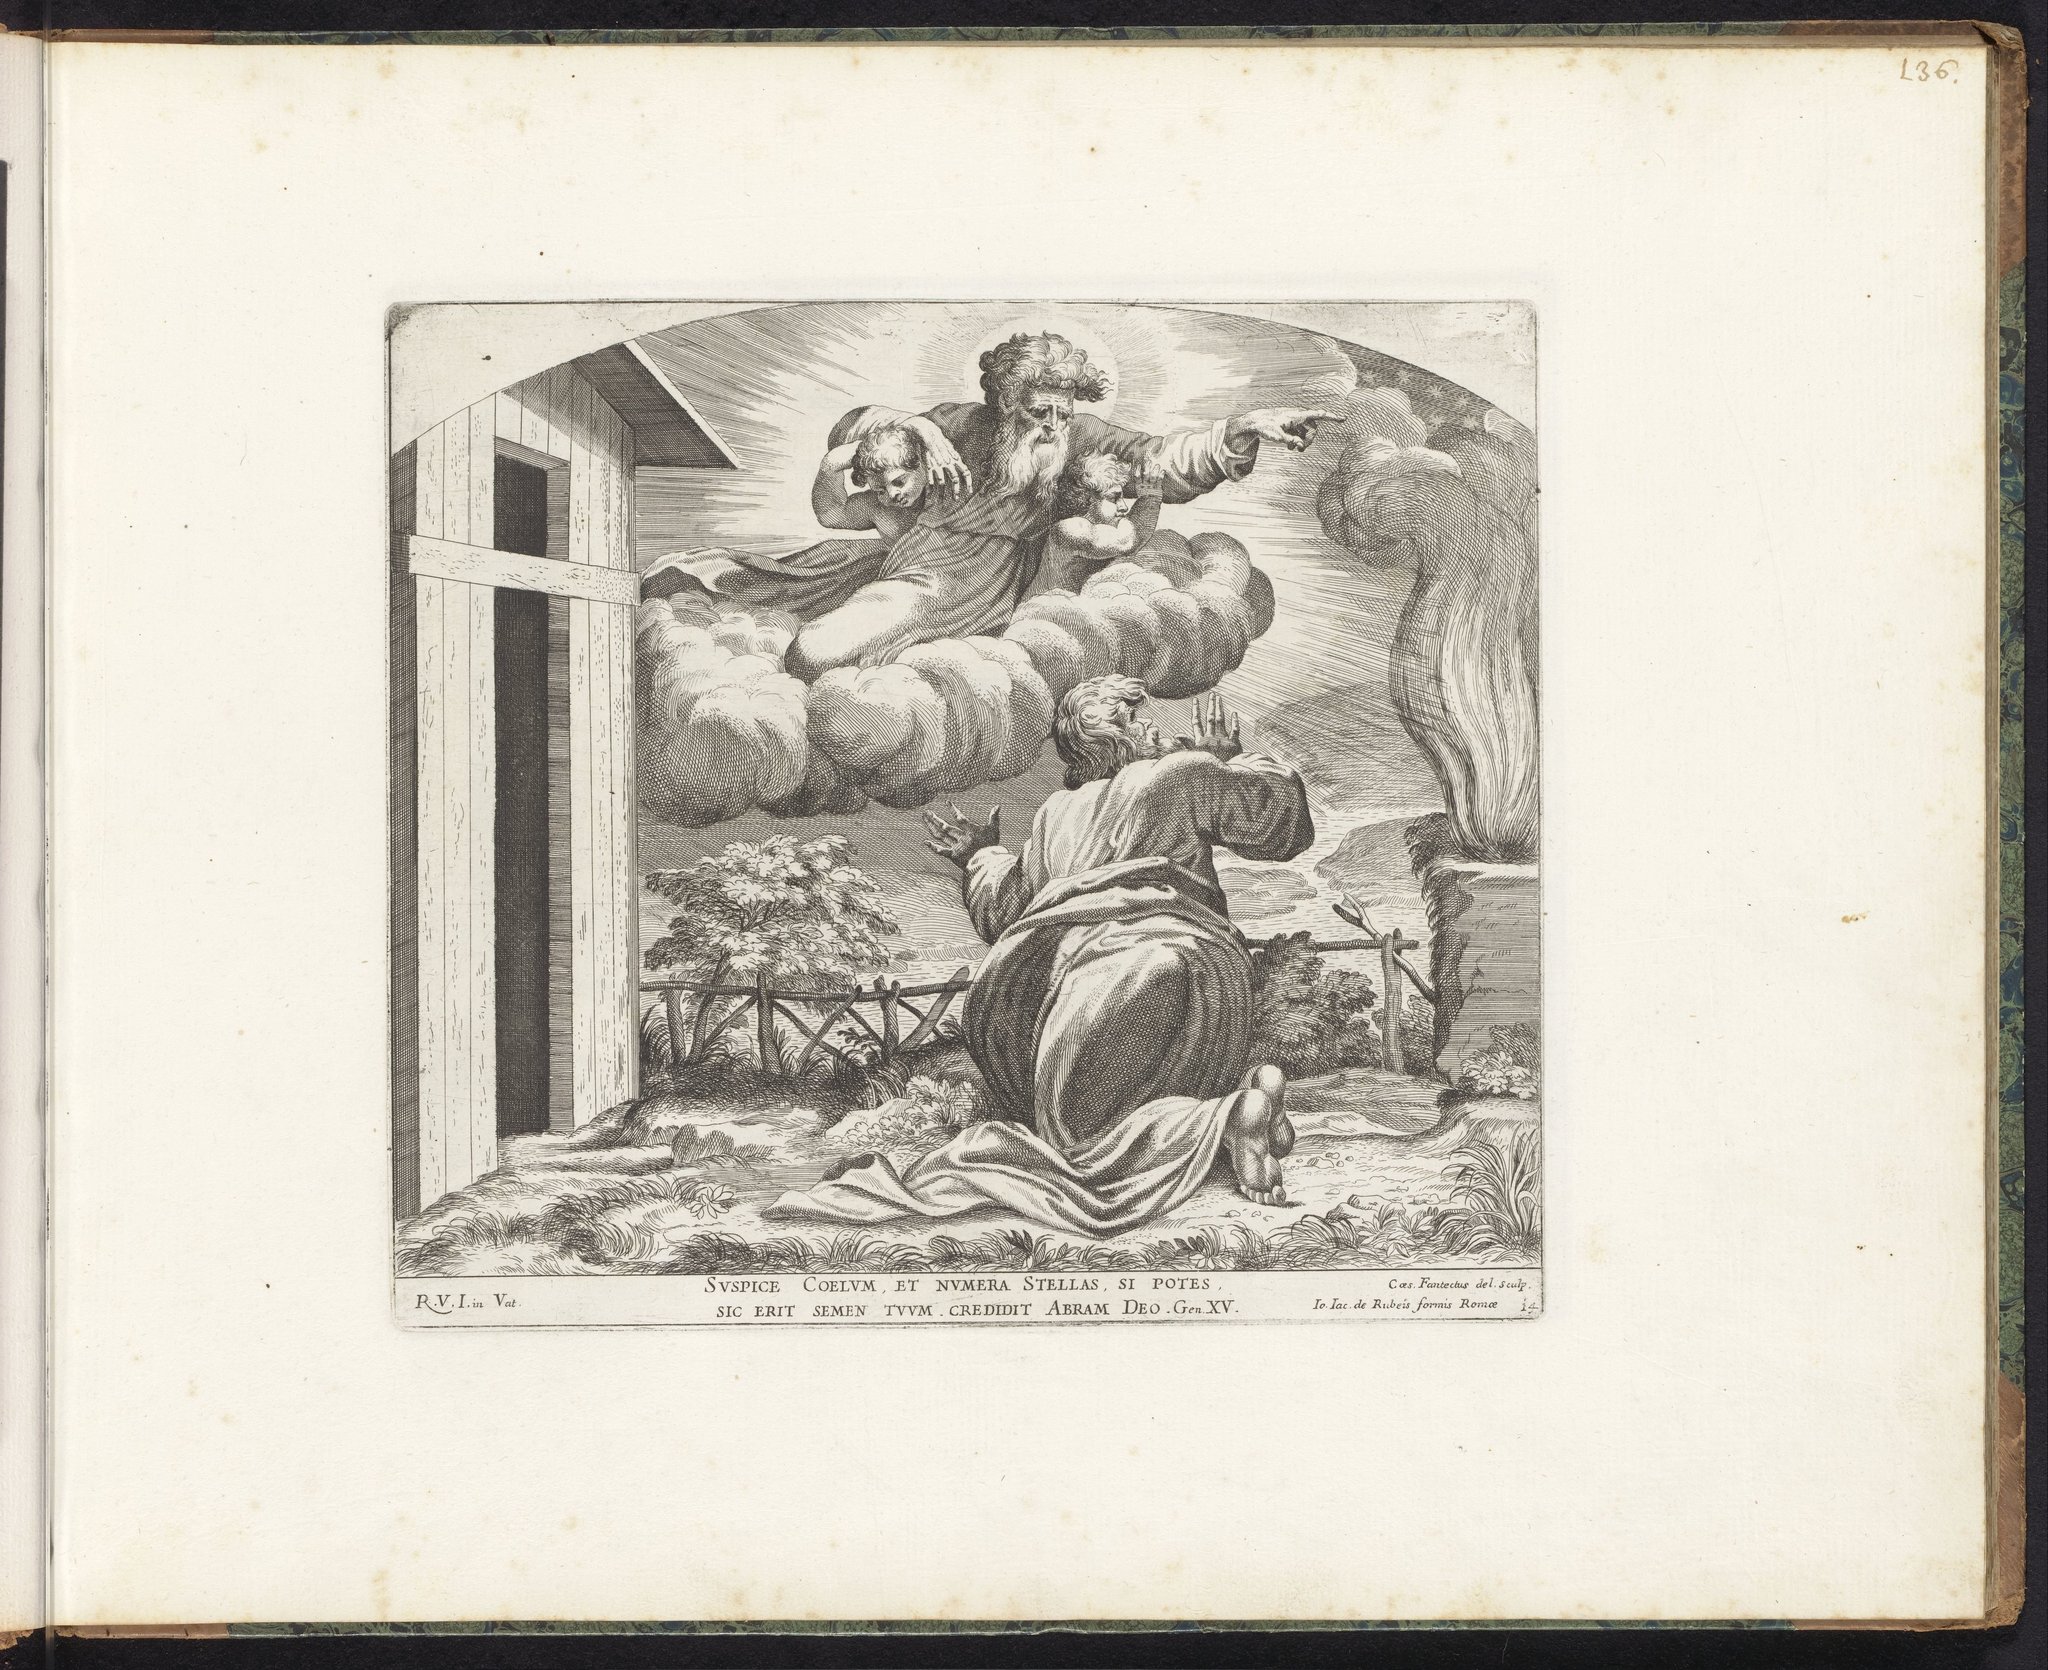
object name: album leaf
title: God vertelt Abraham zijn bestemming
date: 1675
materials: paper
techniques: etching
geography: vatican city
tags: abraham communicating with god (in general)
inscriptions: number: ‘136’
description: Prent maakt deel uit van een reeks van 55 prenten, bestaande uit drie ongenummerde prenten en een set van 52 genummerde prenten naar de schilderingen in de Loggia van Rafaël.